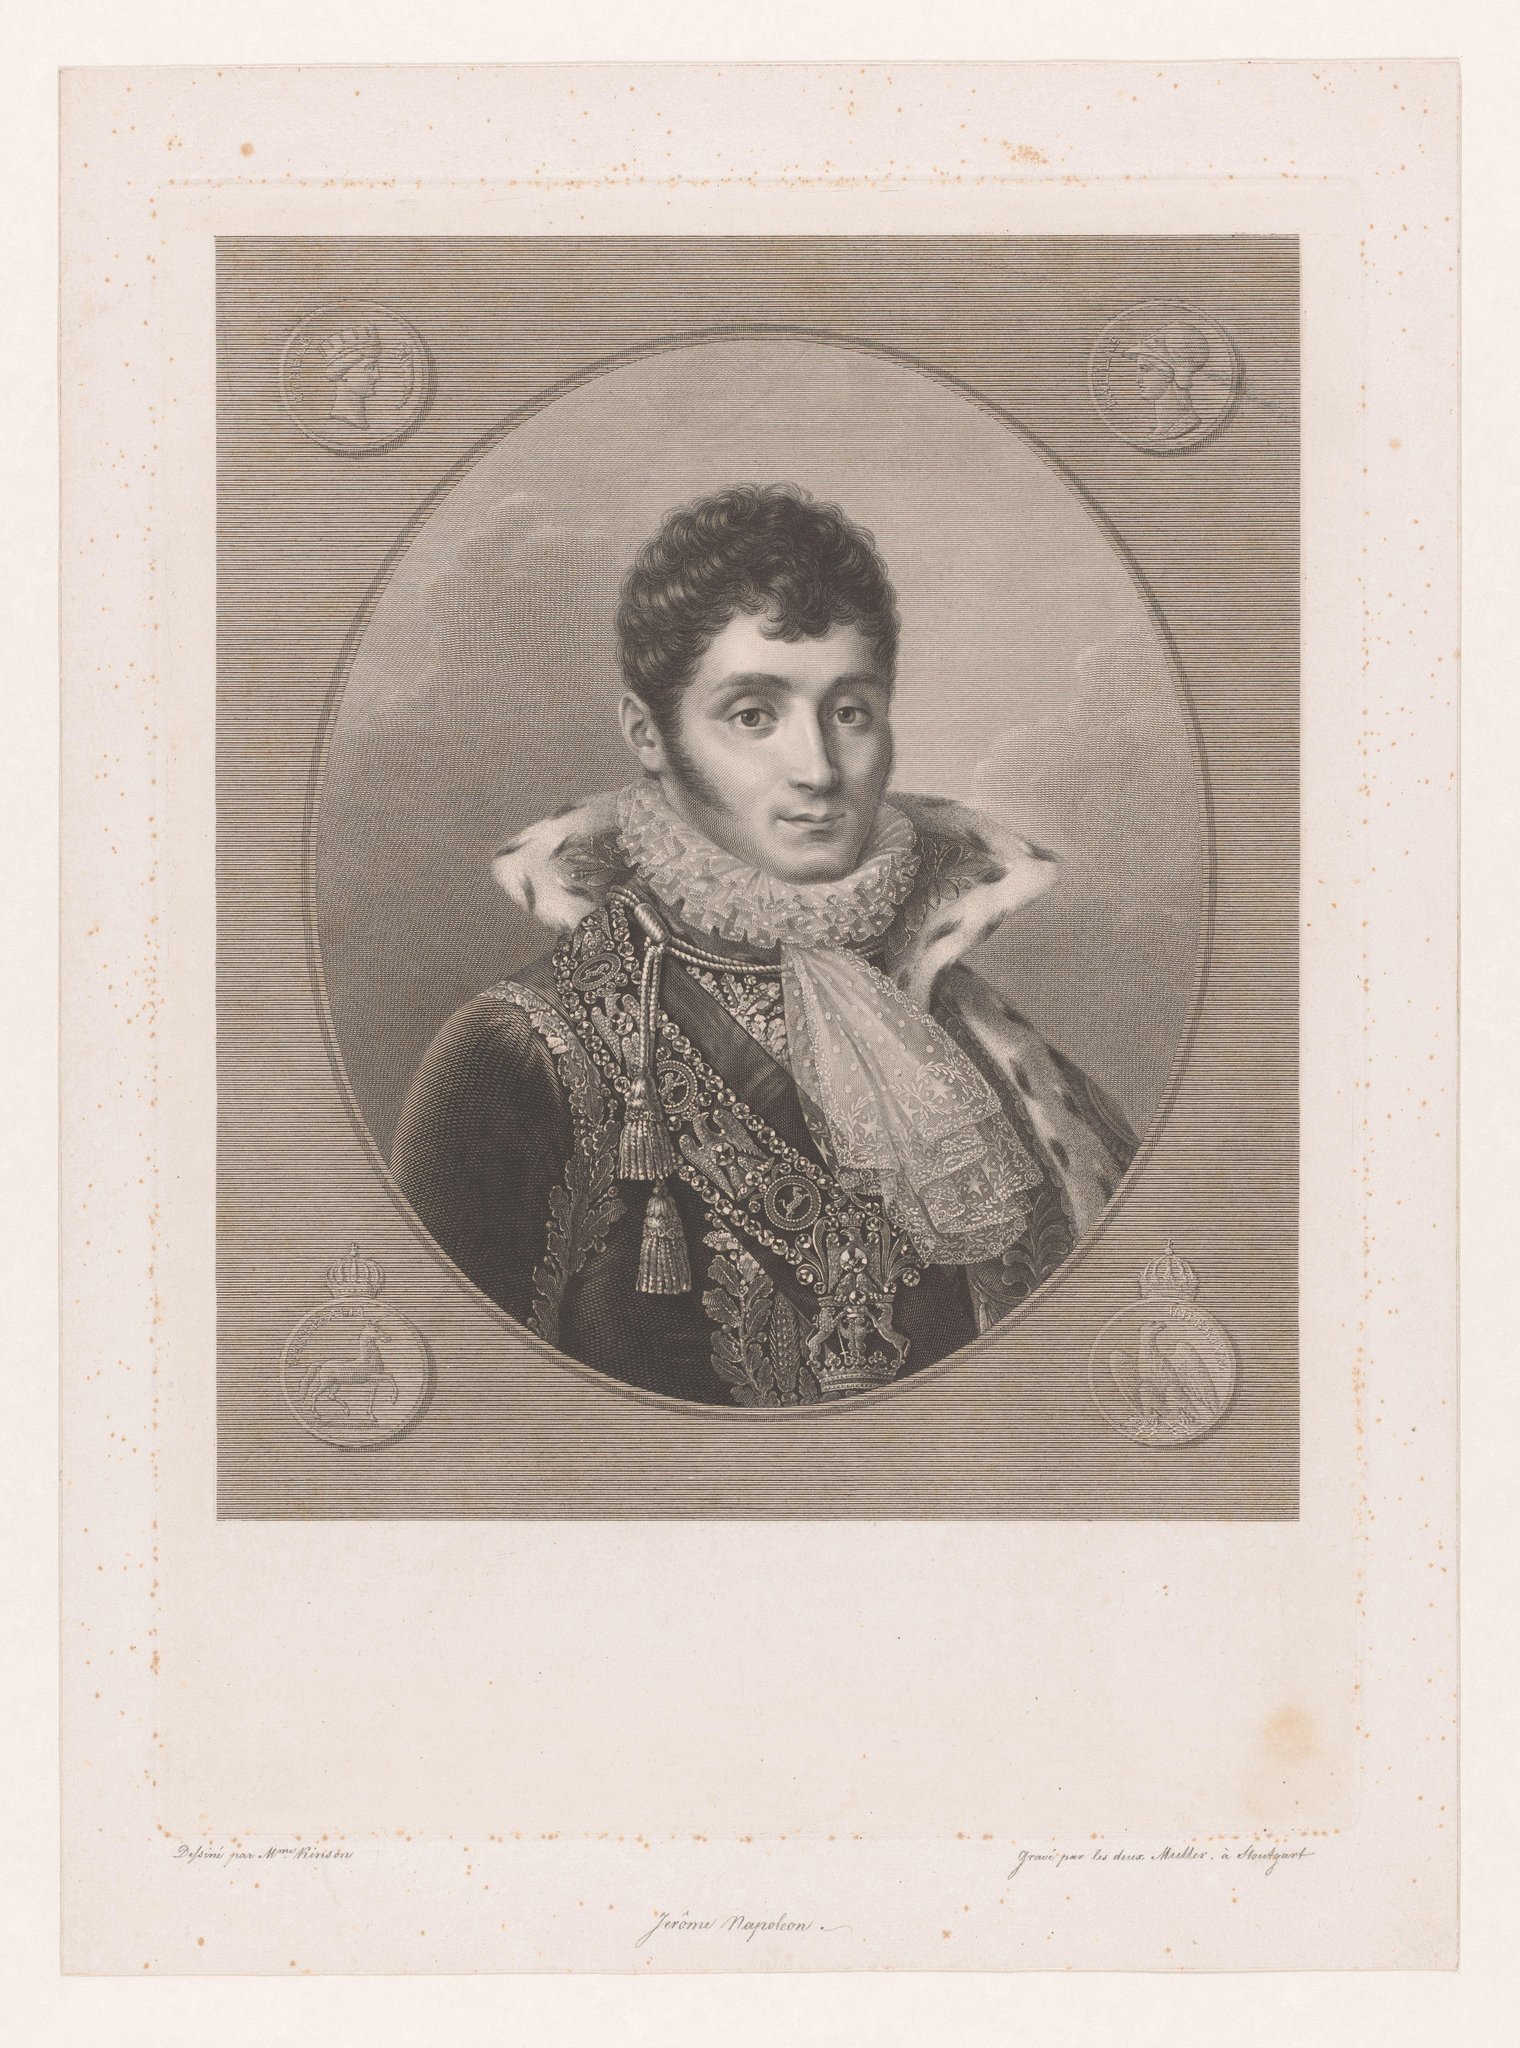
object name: print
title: Portret van Jerôme Bonaparte, koning van Westfalen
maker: johann gotthard müller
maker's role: print maker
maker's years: 1747-1830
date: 1807-1825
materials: paper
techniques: engraving, etching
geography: stuttgart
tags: paris, historical persons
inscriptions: collector's mark: Lugt 12